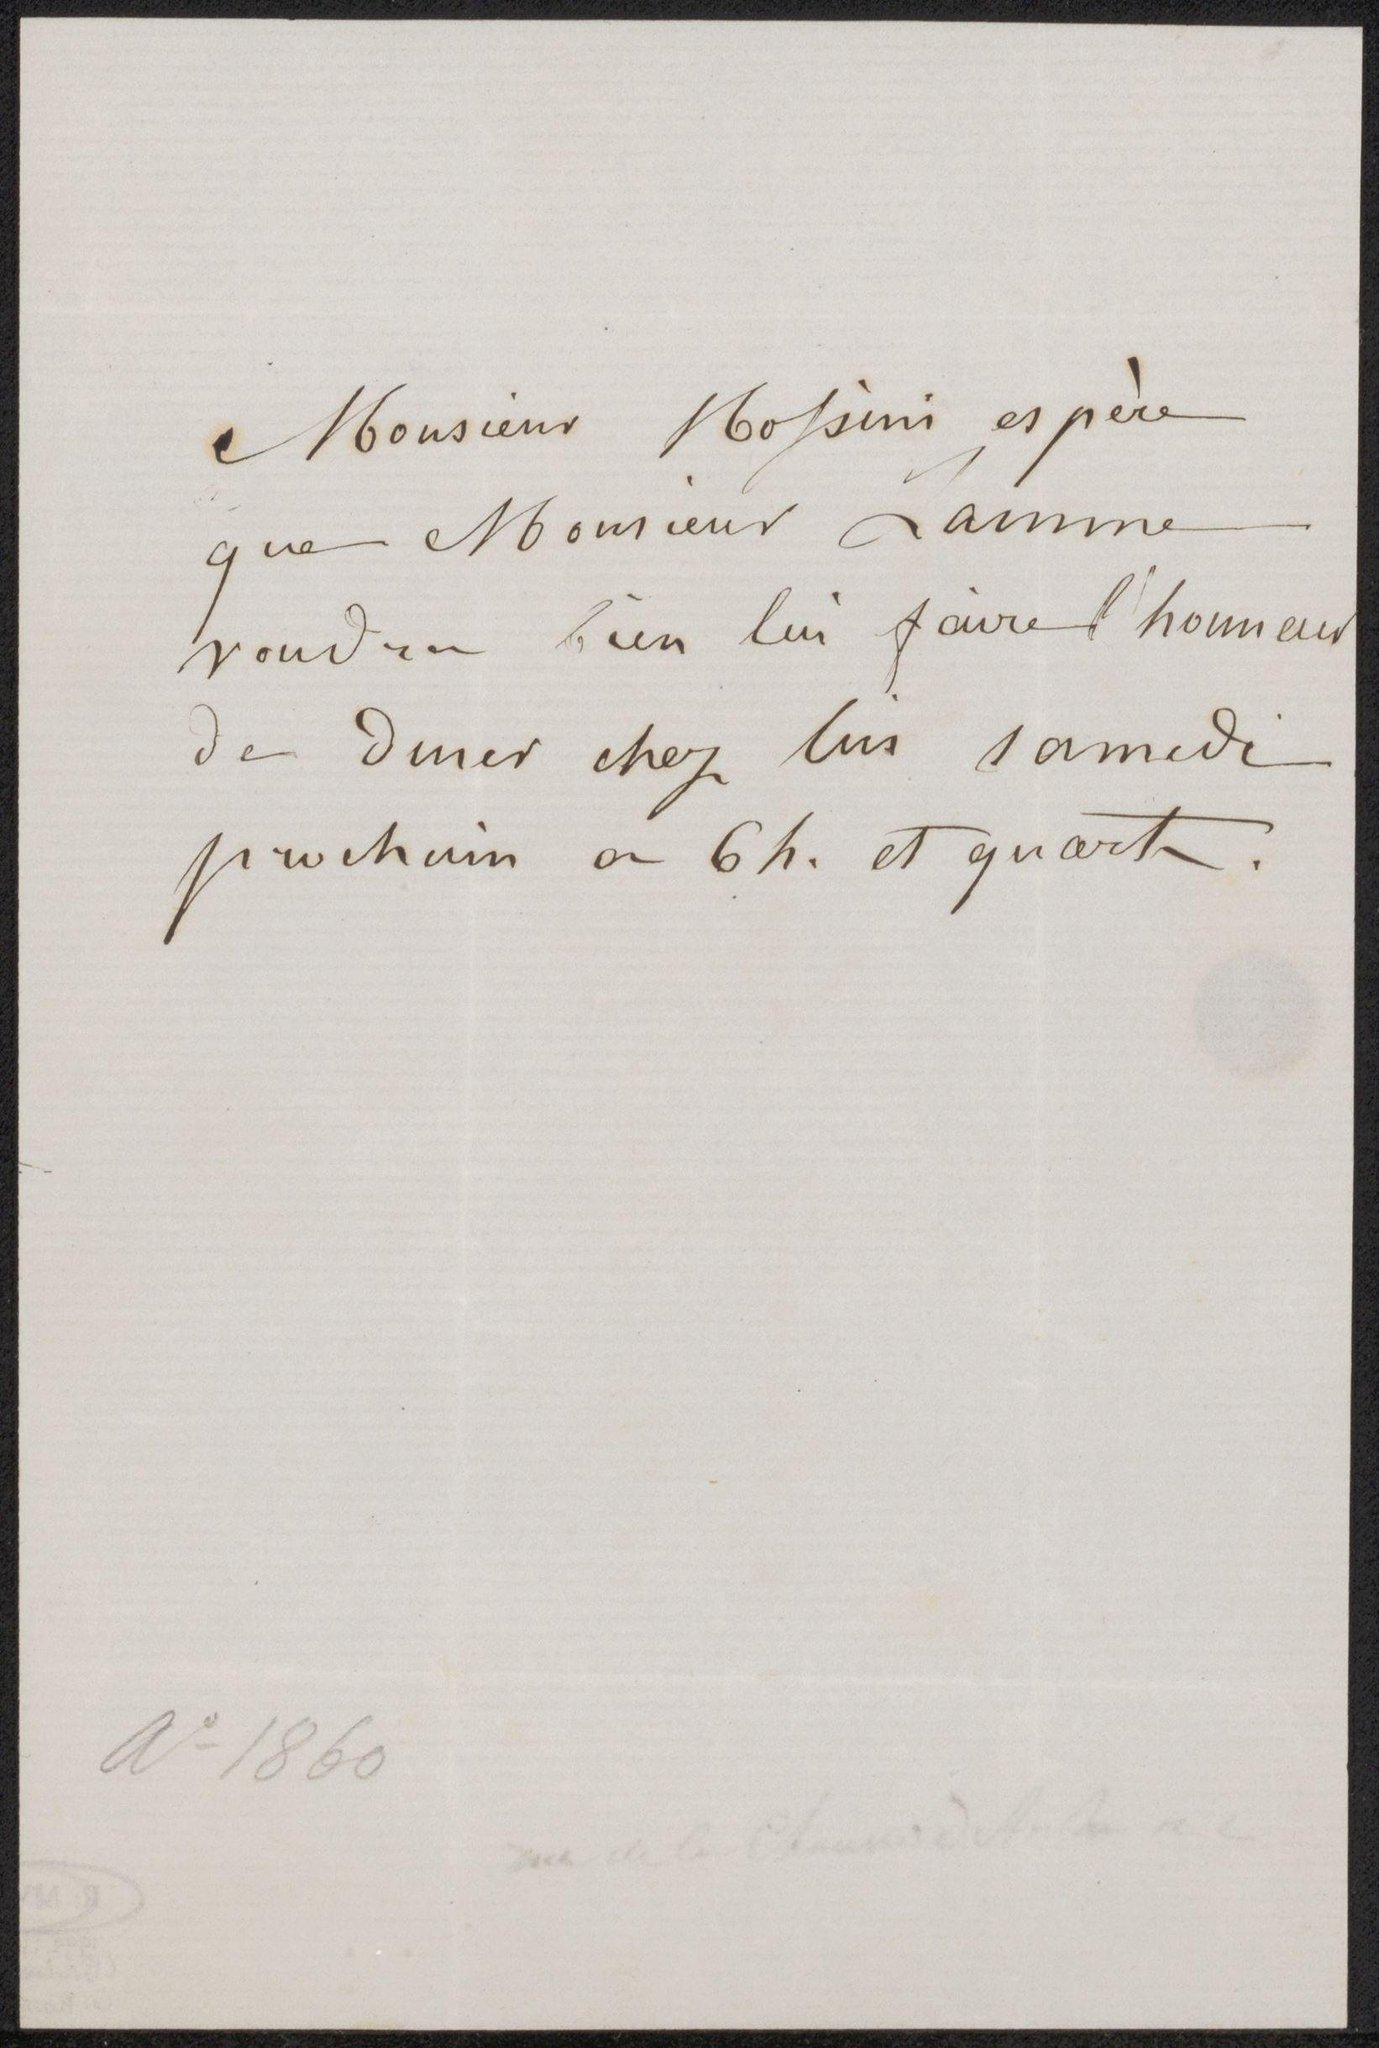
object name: letter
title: Brief aan Ary Johannes Lamme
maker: gioacchino antonio rossini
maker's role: componist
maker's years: 1792-1868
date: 1824-1868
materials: ink, paper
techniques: pen, writing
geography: paris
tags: dordrecht, print maker, draughtsman, ary johannes lamme, paris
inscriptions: watermark, collector's mark: Lugt 2228